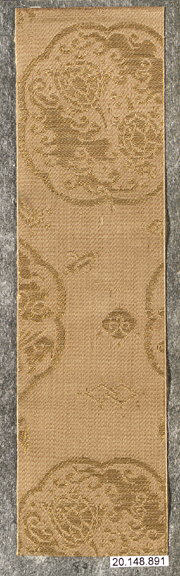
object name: piece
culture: chinese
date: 1701-1800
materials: silk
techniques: compound weave